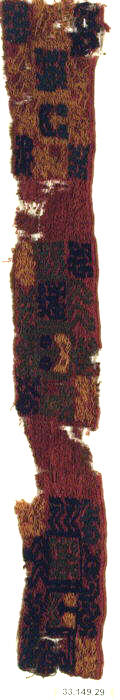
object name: border fragment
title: Embroidered Border Fragment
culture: paracas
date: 500-101 BCE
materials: animal fiber, cotton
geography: peru